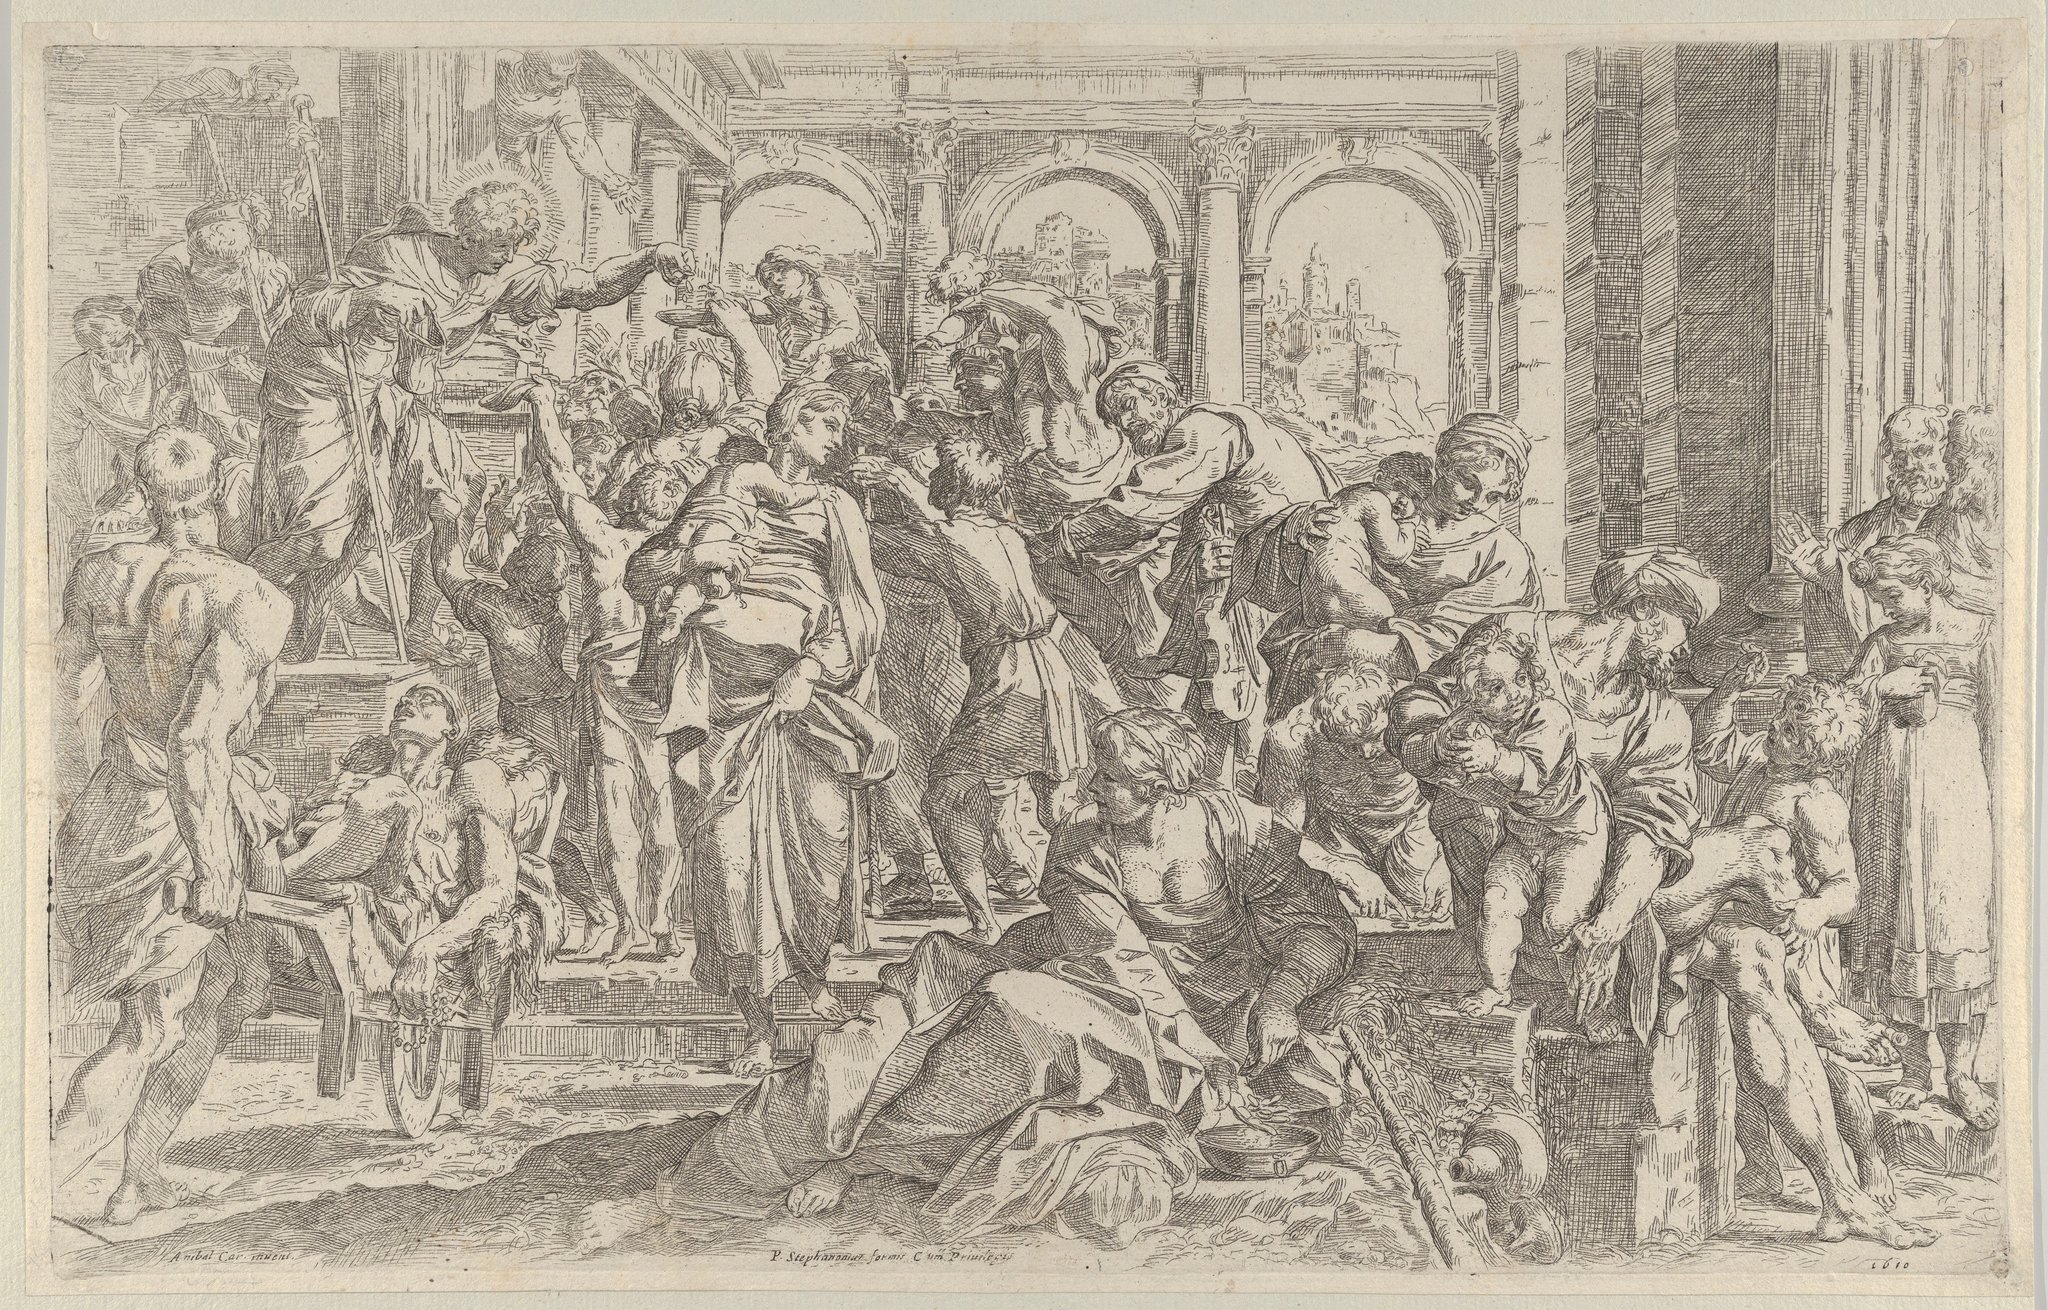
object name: print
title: Saint Roch at left distributing alms to a group of people gathered around him, after Annibale Caracci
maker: francesco brizio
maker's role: artist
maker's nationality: italian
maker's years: 1569-1623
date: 1590-1600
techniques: etching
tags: children,men,women,saints